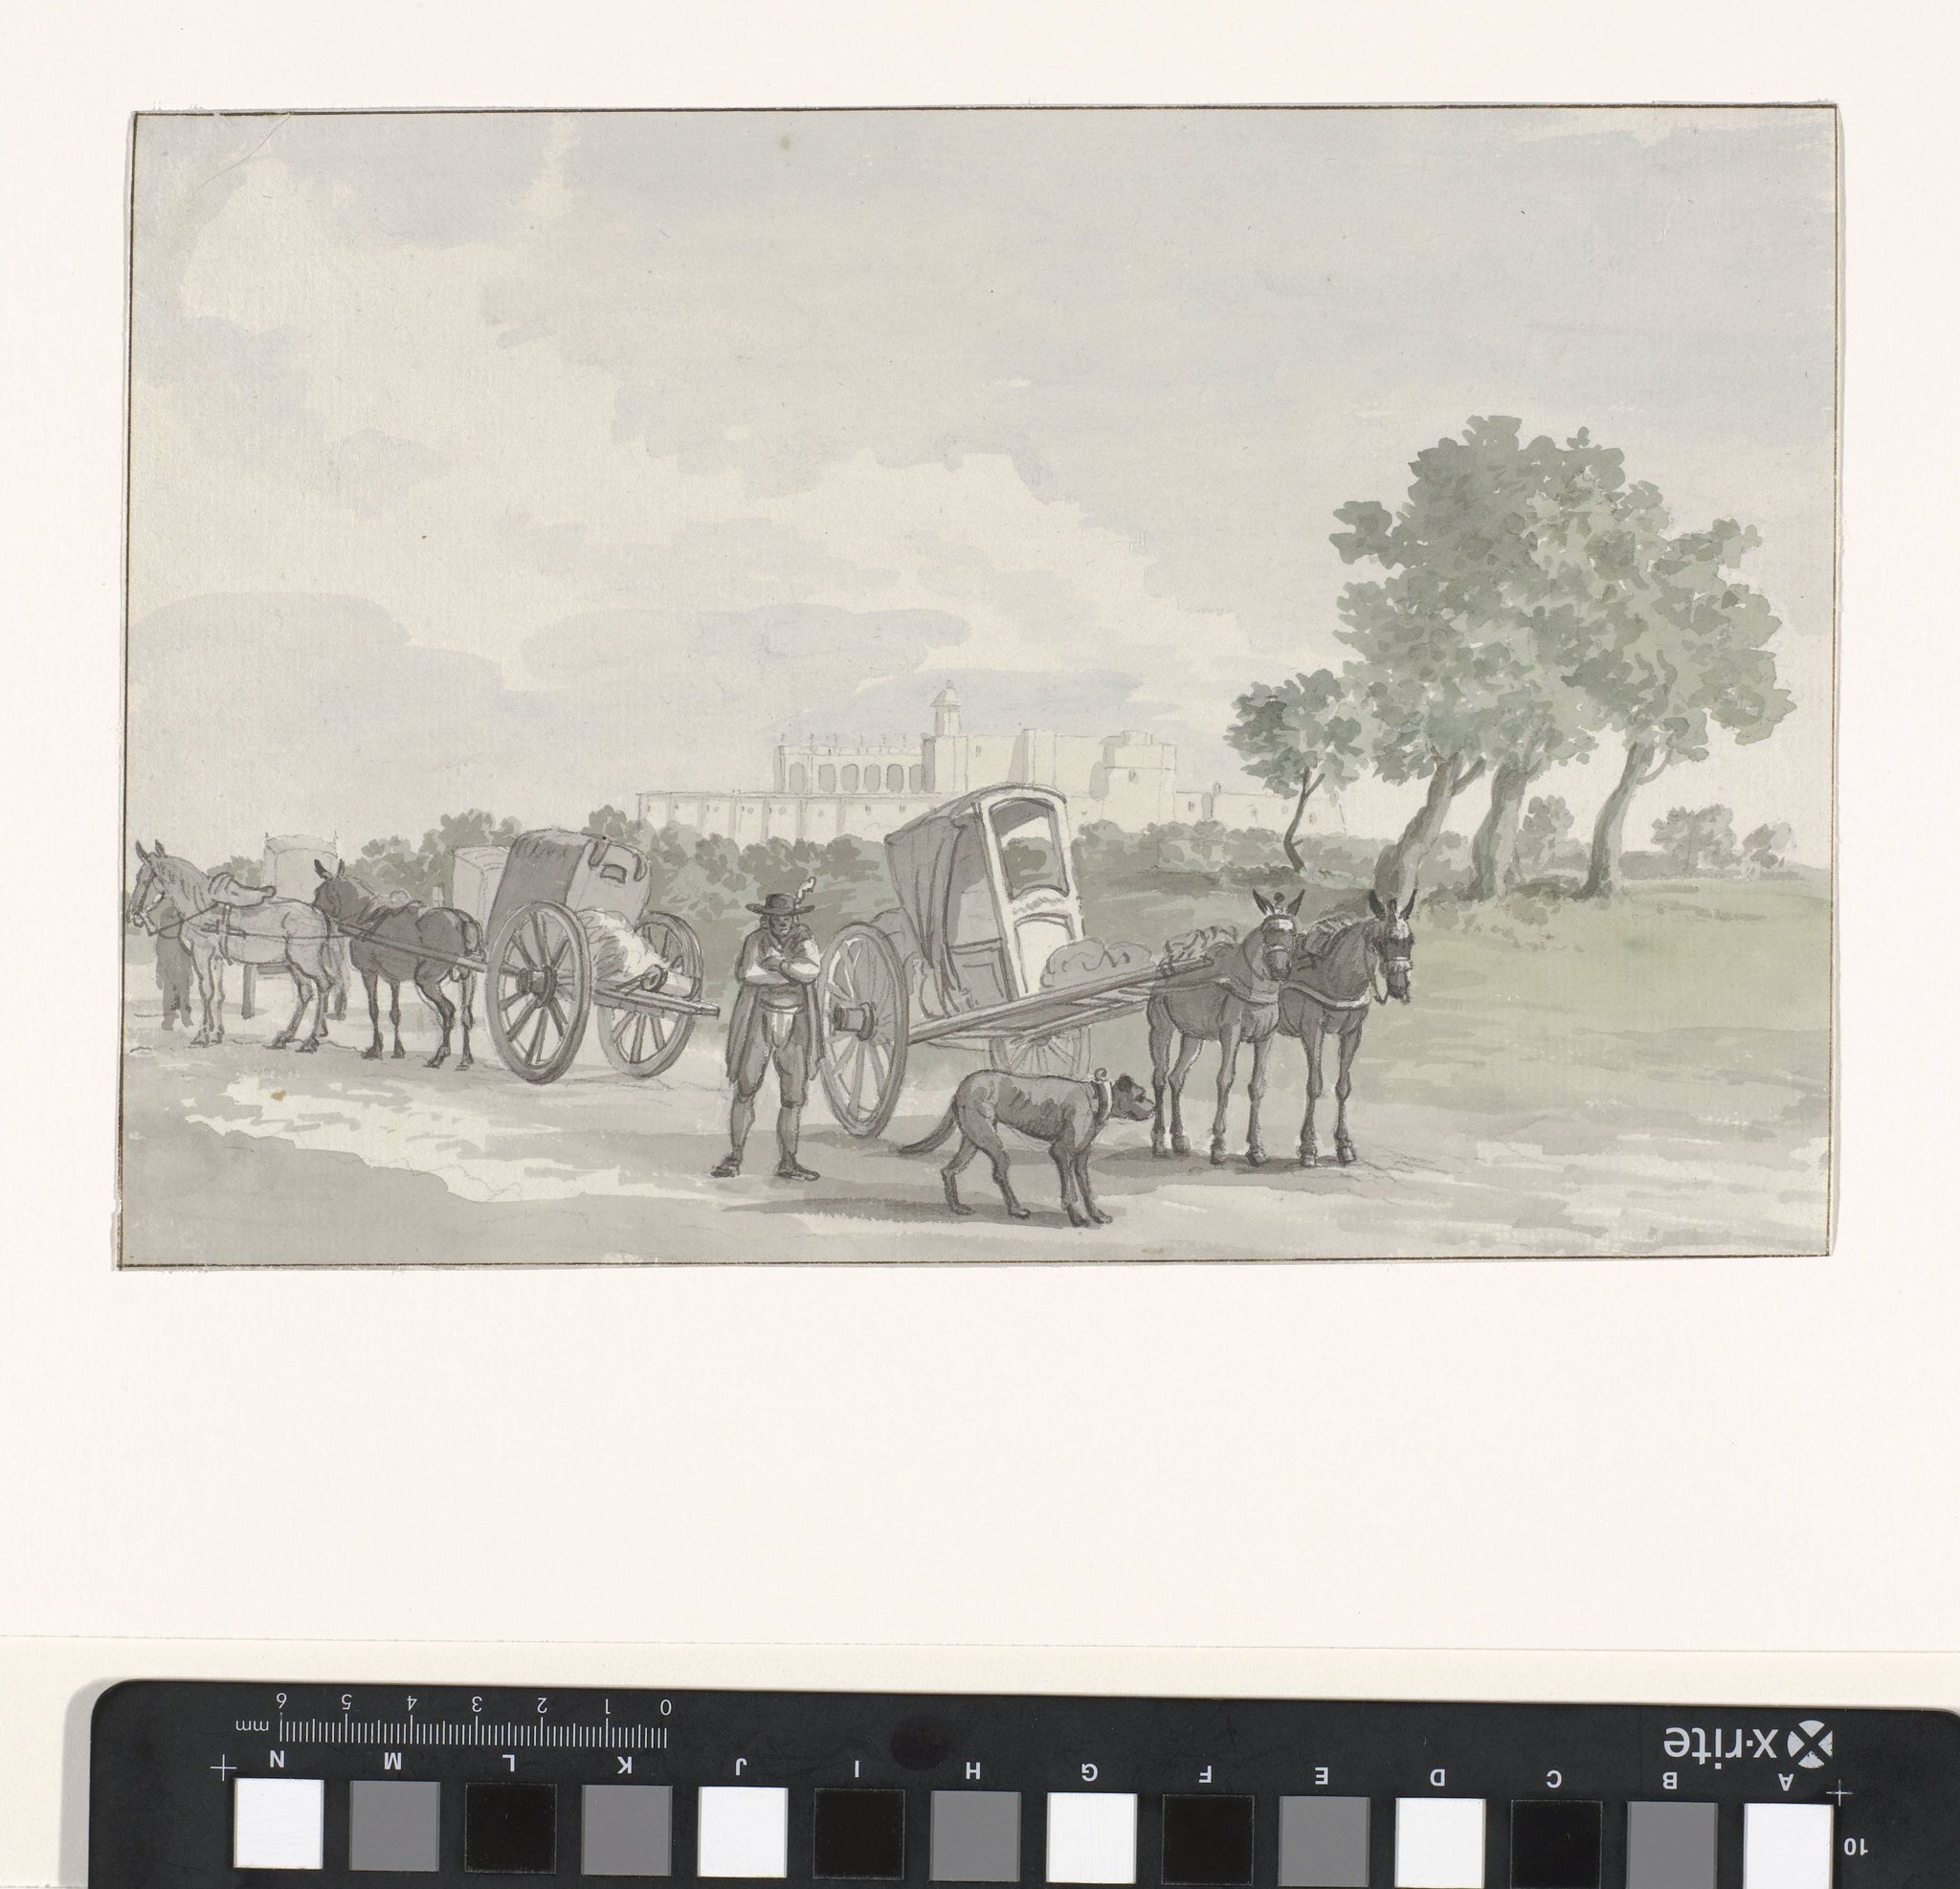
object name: drawing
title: Voyage en Italie, en Sicile et à Malte - 1778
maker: louis ducros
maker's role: draughtsman, print maker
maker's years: 1748-1810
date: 1778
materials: chalk, paper, pencil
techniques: brush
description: Tekening uit het album 'Voyage en Italie, en Sicile et à Malte', 1778.